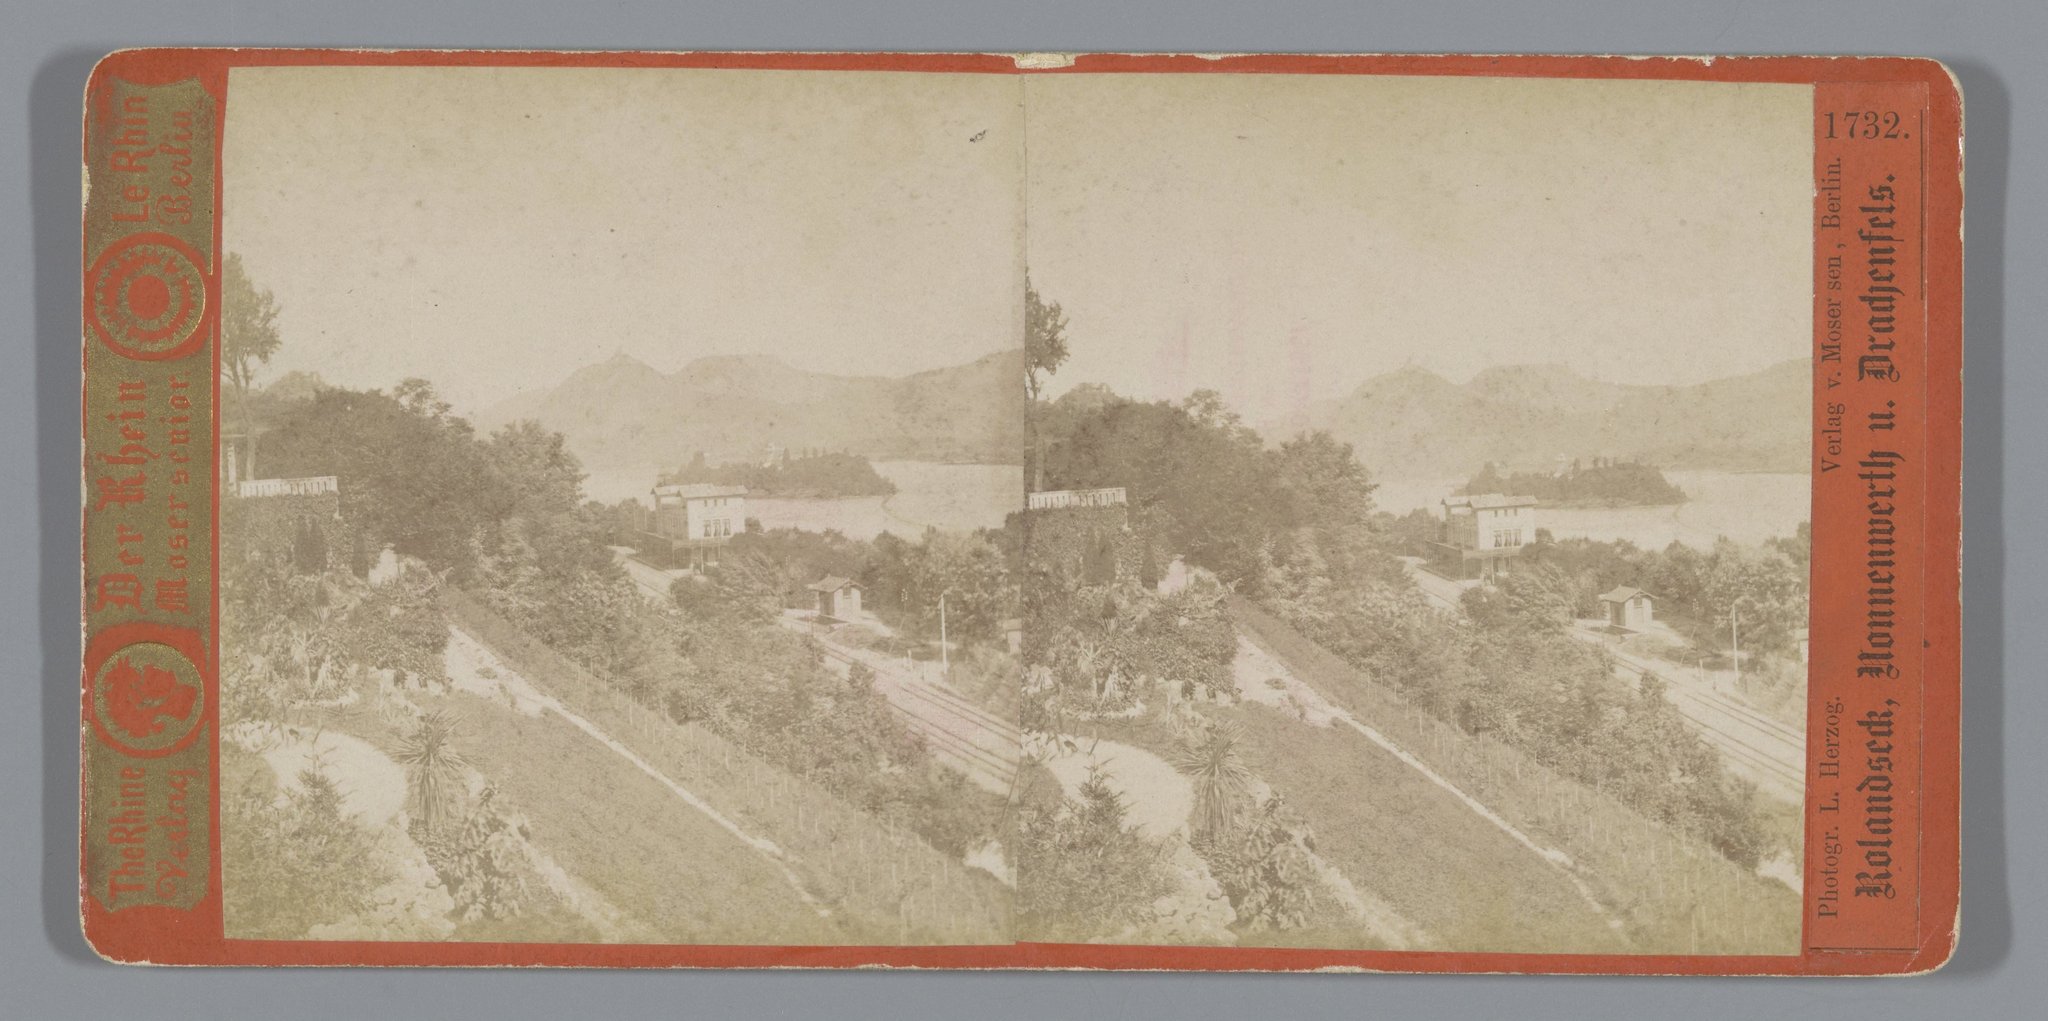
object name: stereograph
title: Rolandseck, Nonnenwerth u. Drachenfels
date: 1850-1880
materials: cardboard, photographic support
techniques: albumen print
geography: rhineland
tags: island, city-view in general; 'veduta'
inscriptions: number: ‘1732.’, inscription: ‘Photographischer und stereoscopischer Kunstverlag (...) Glas-u. Papier- Stereoscopbildern aller Weltgegenden’